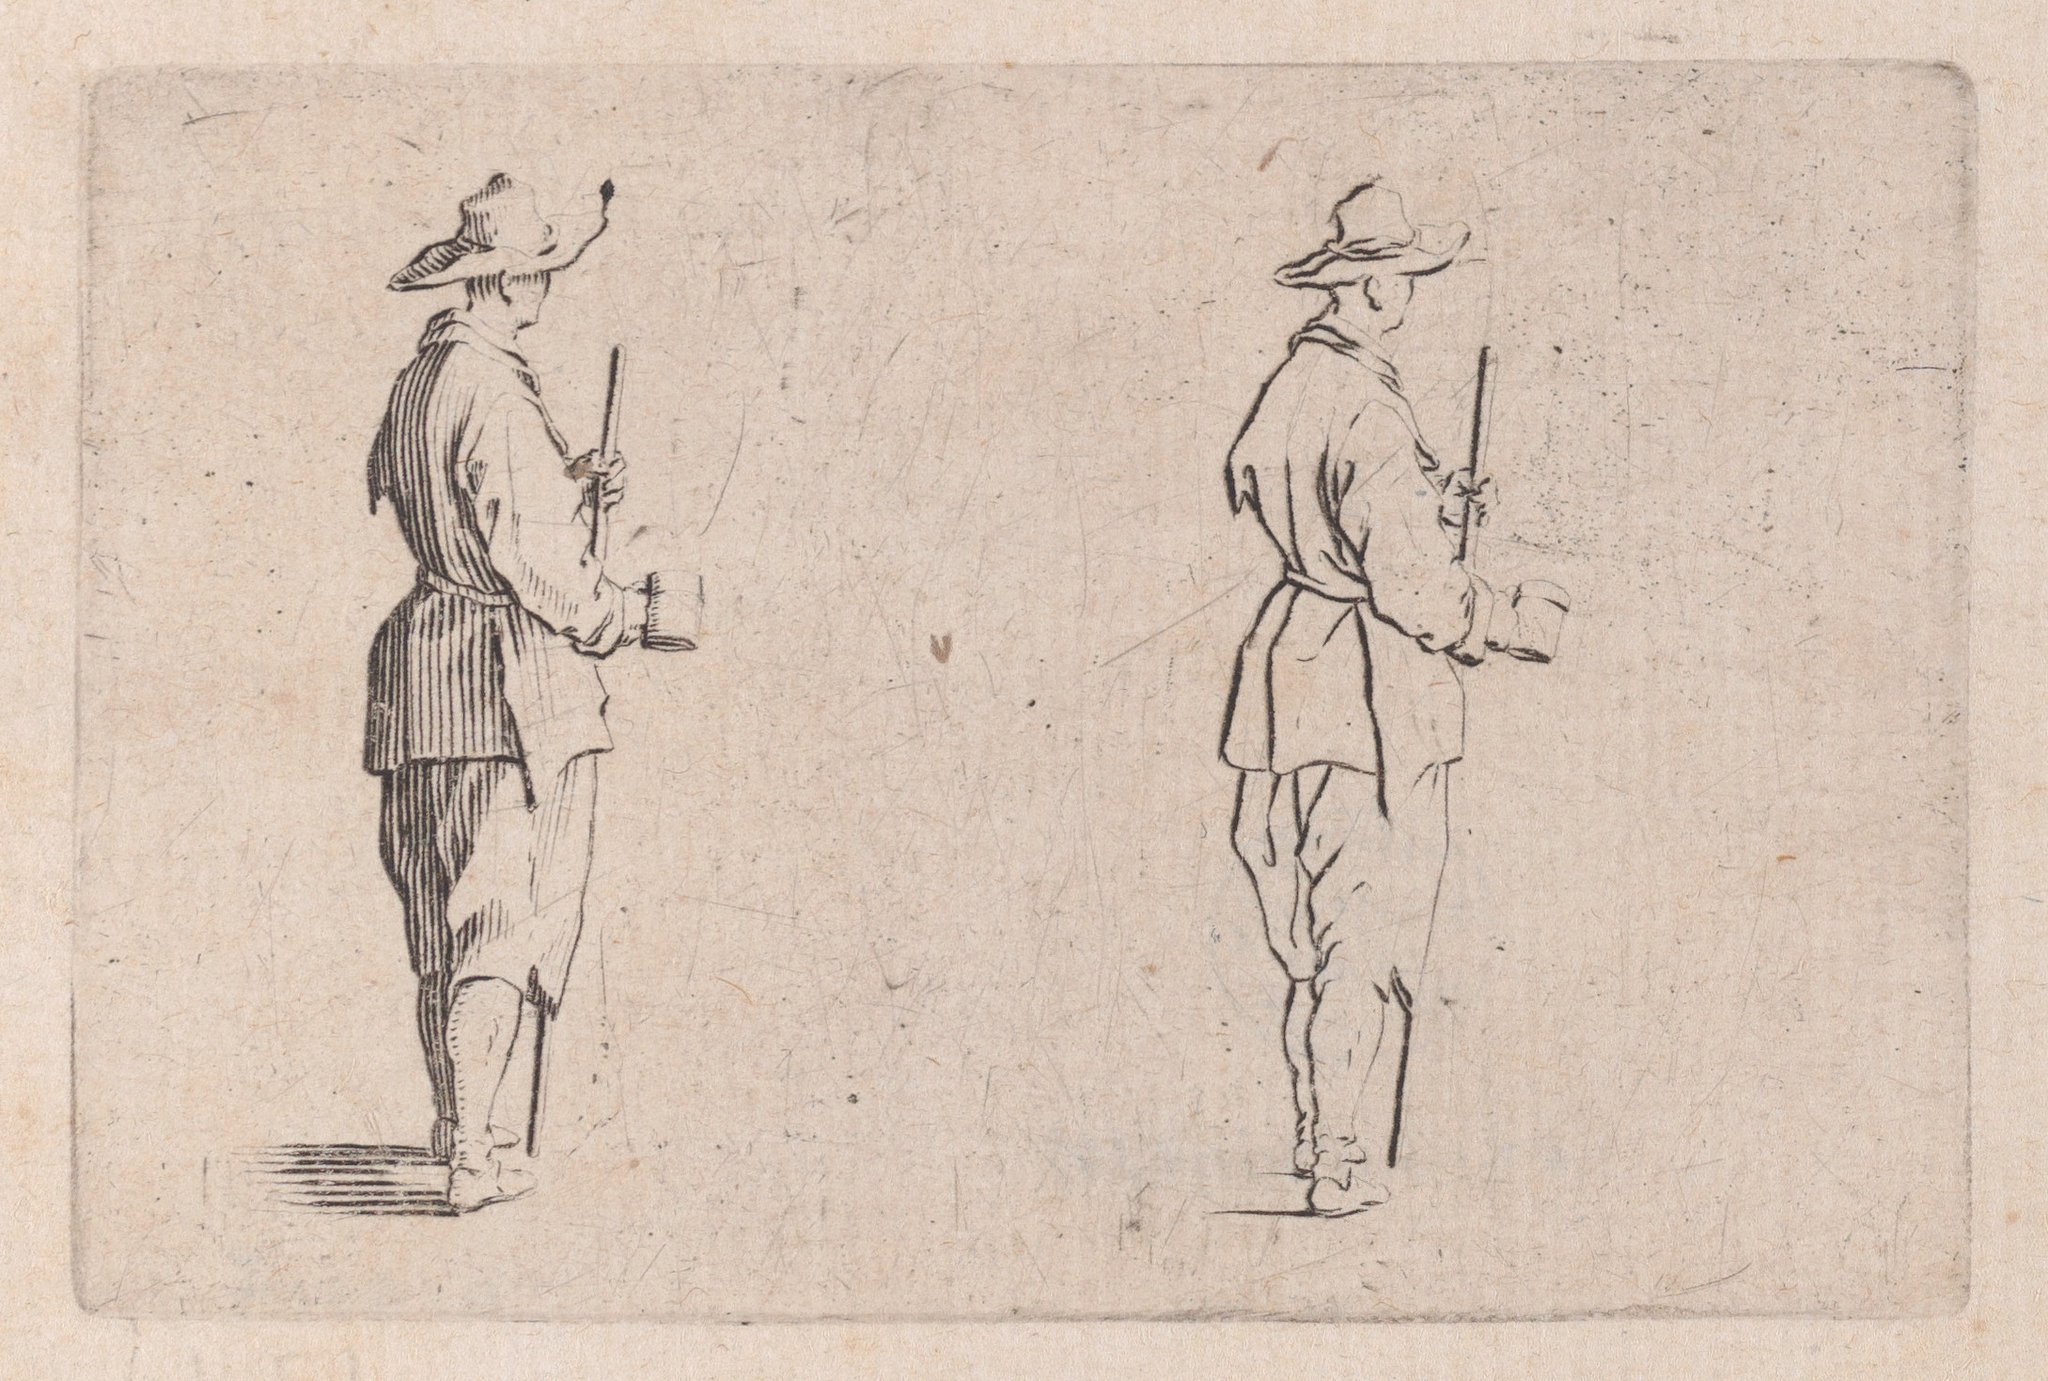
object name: print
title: Le Paysan Tenant un Gobelet (The Peasant Holding a Cup), from "Les Caprices" Series B, The Nancy Set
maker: jacques callot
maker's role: artist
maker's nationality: french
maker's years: 1592-1635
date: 1617-1620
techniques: etching